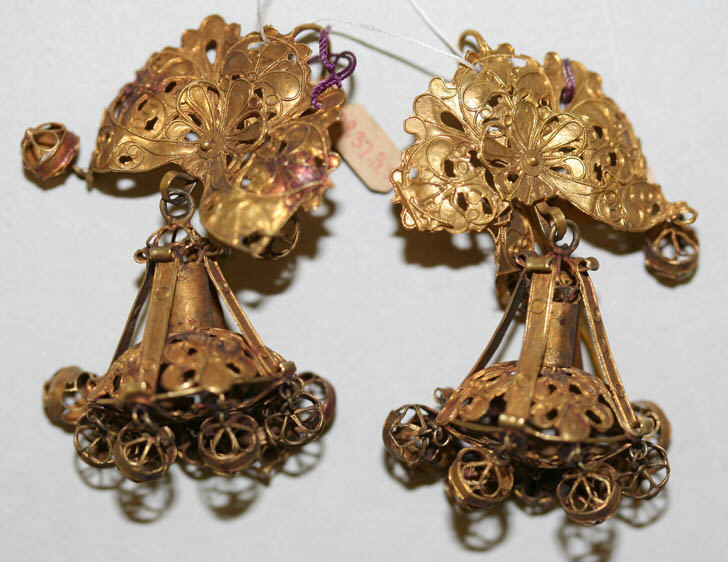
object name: earring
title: Earrings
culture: european, eastern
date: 1701-1900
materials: metal